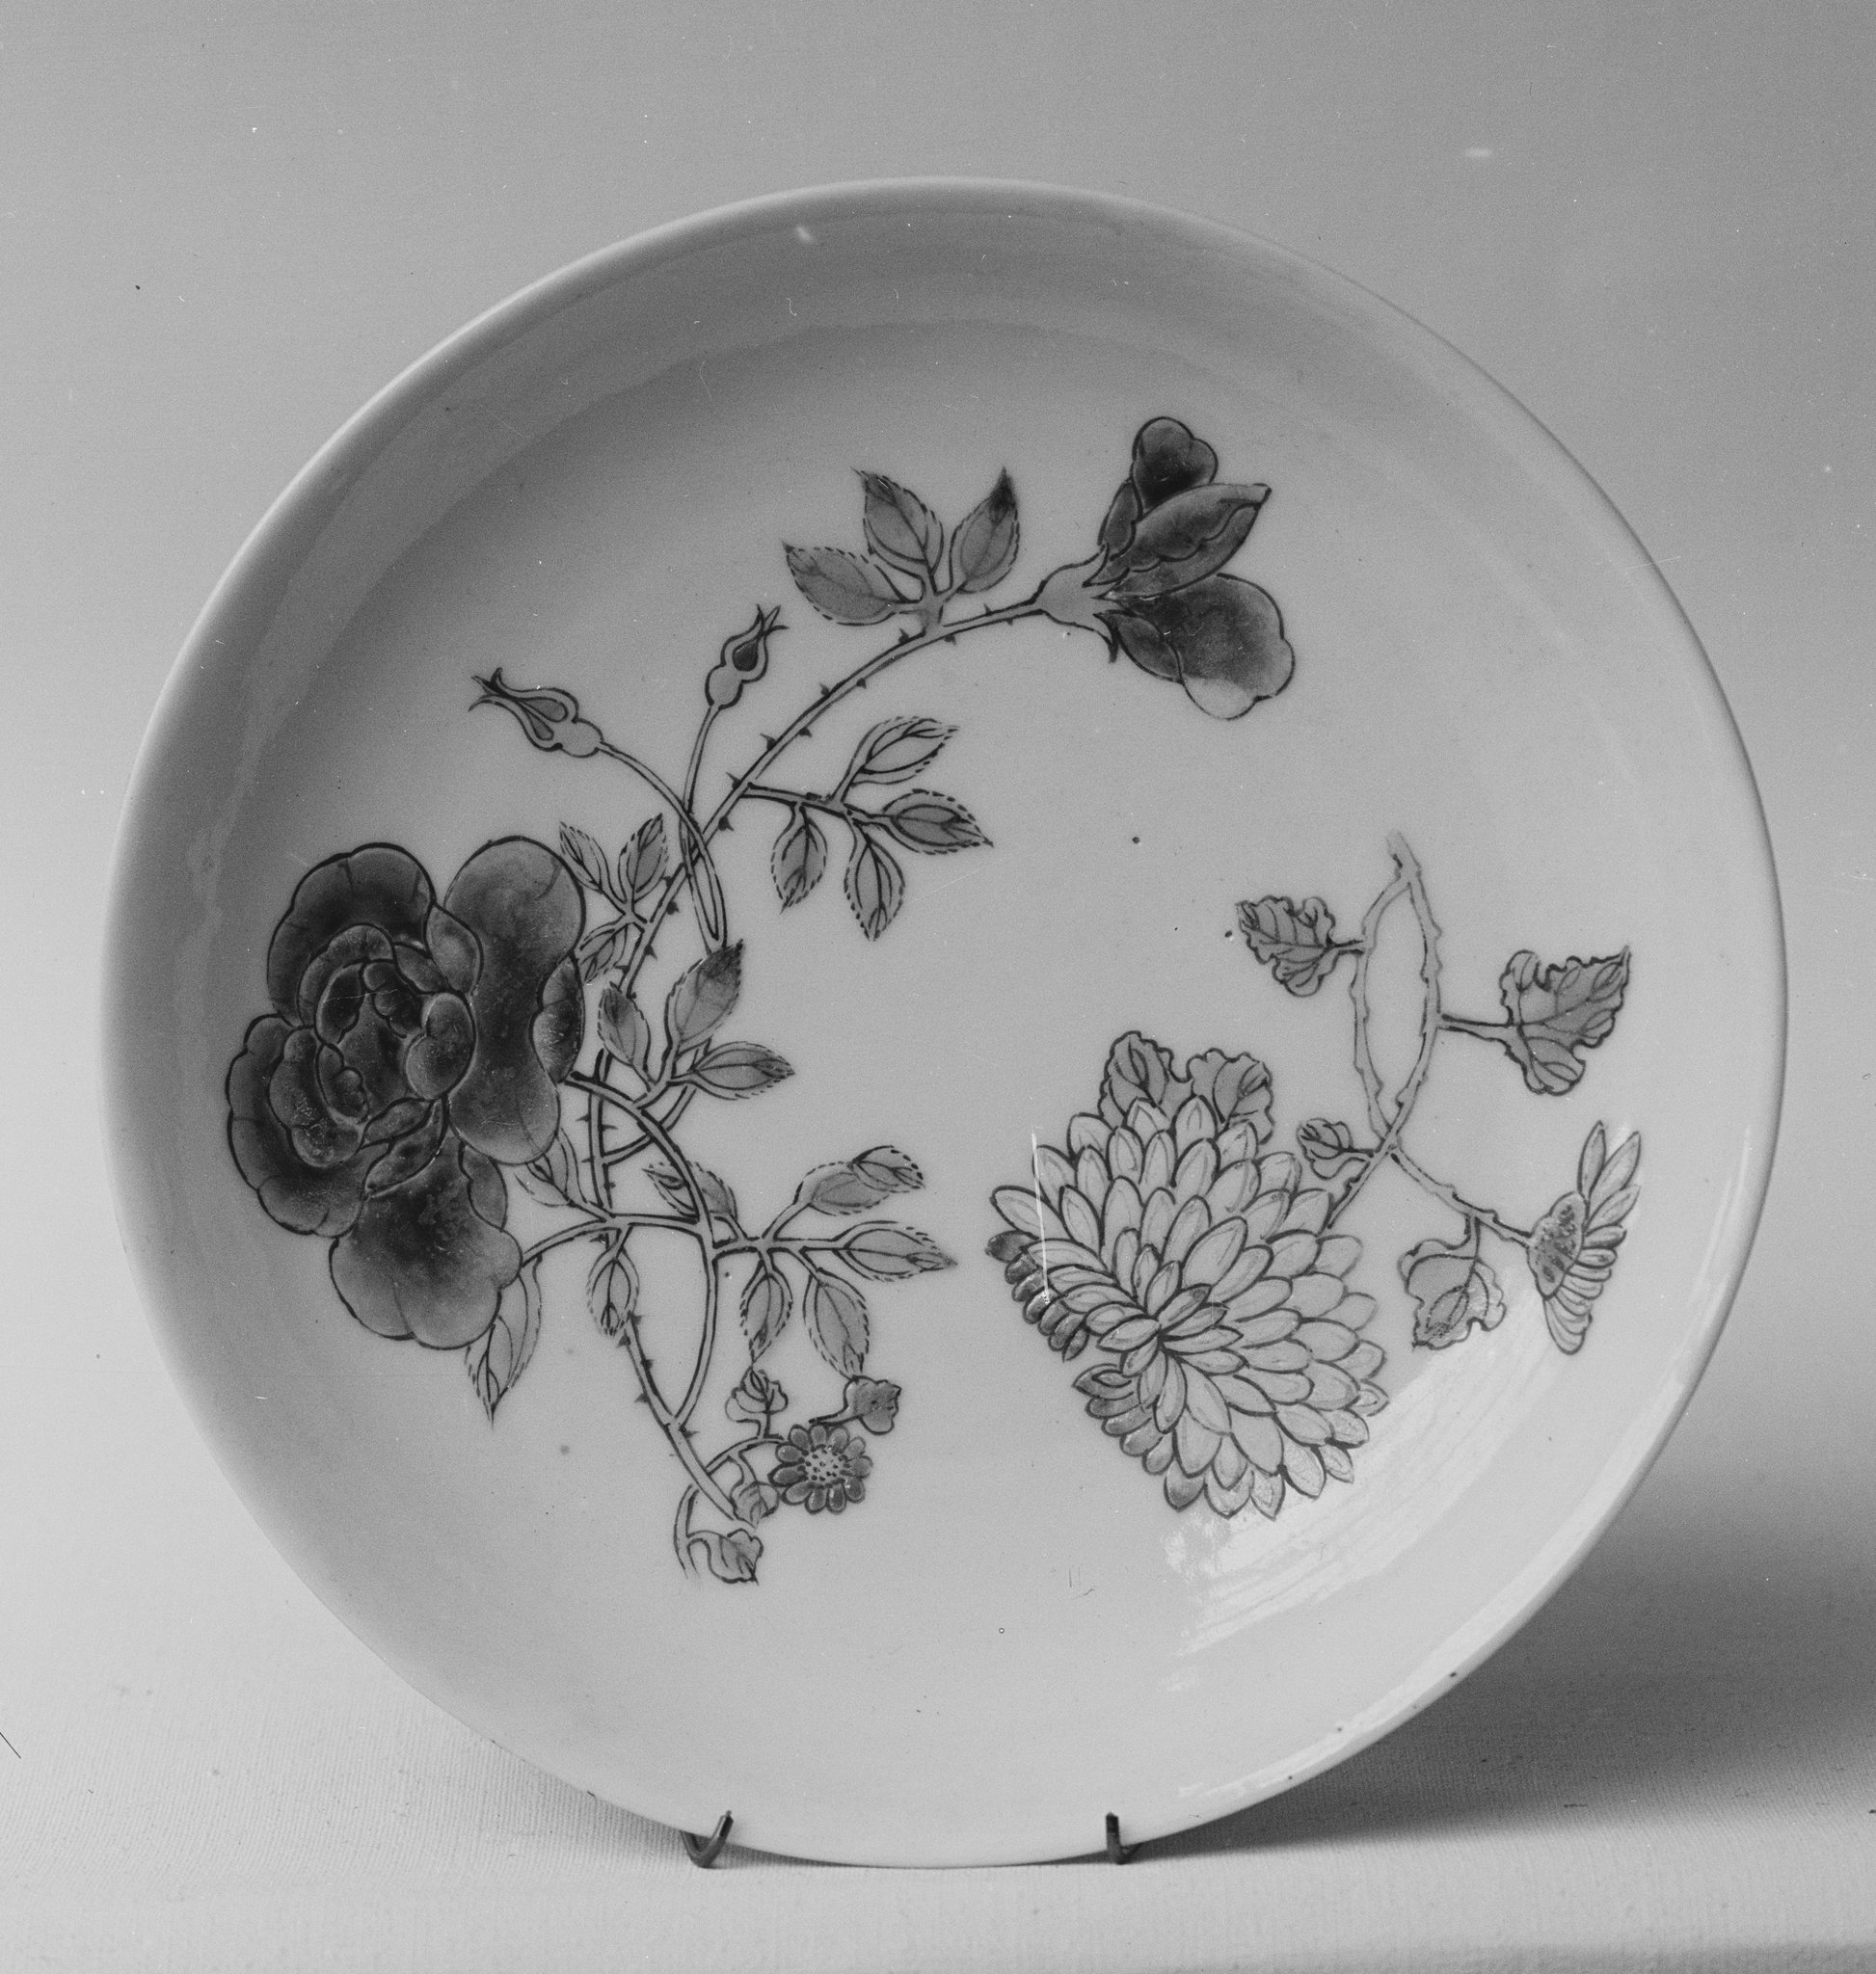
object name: saucer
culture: chinese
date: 1801-1850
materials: enamel, glaze, porcelain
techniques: overglaze, painting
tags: flowers